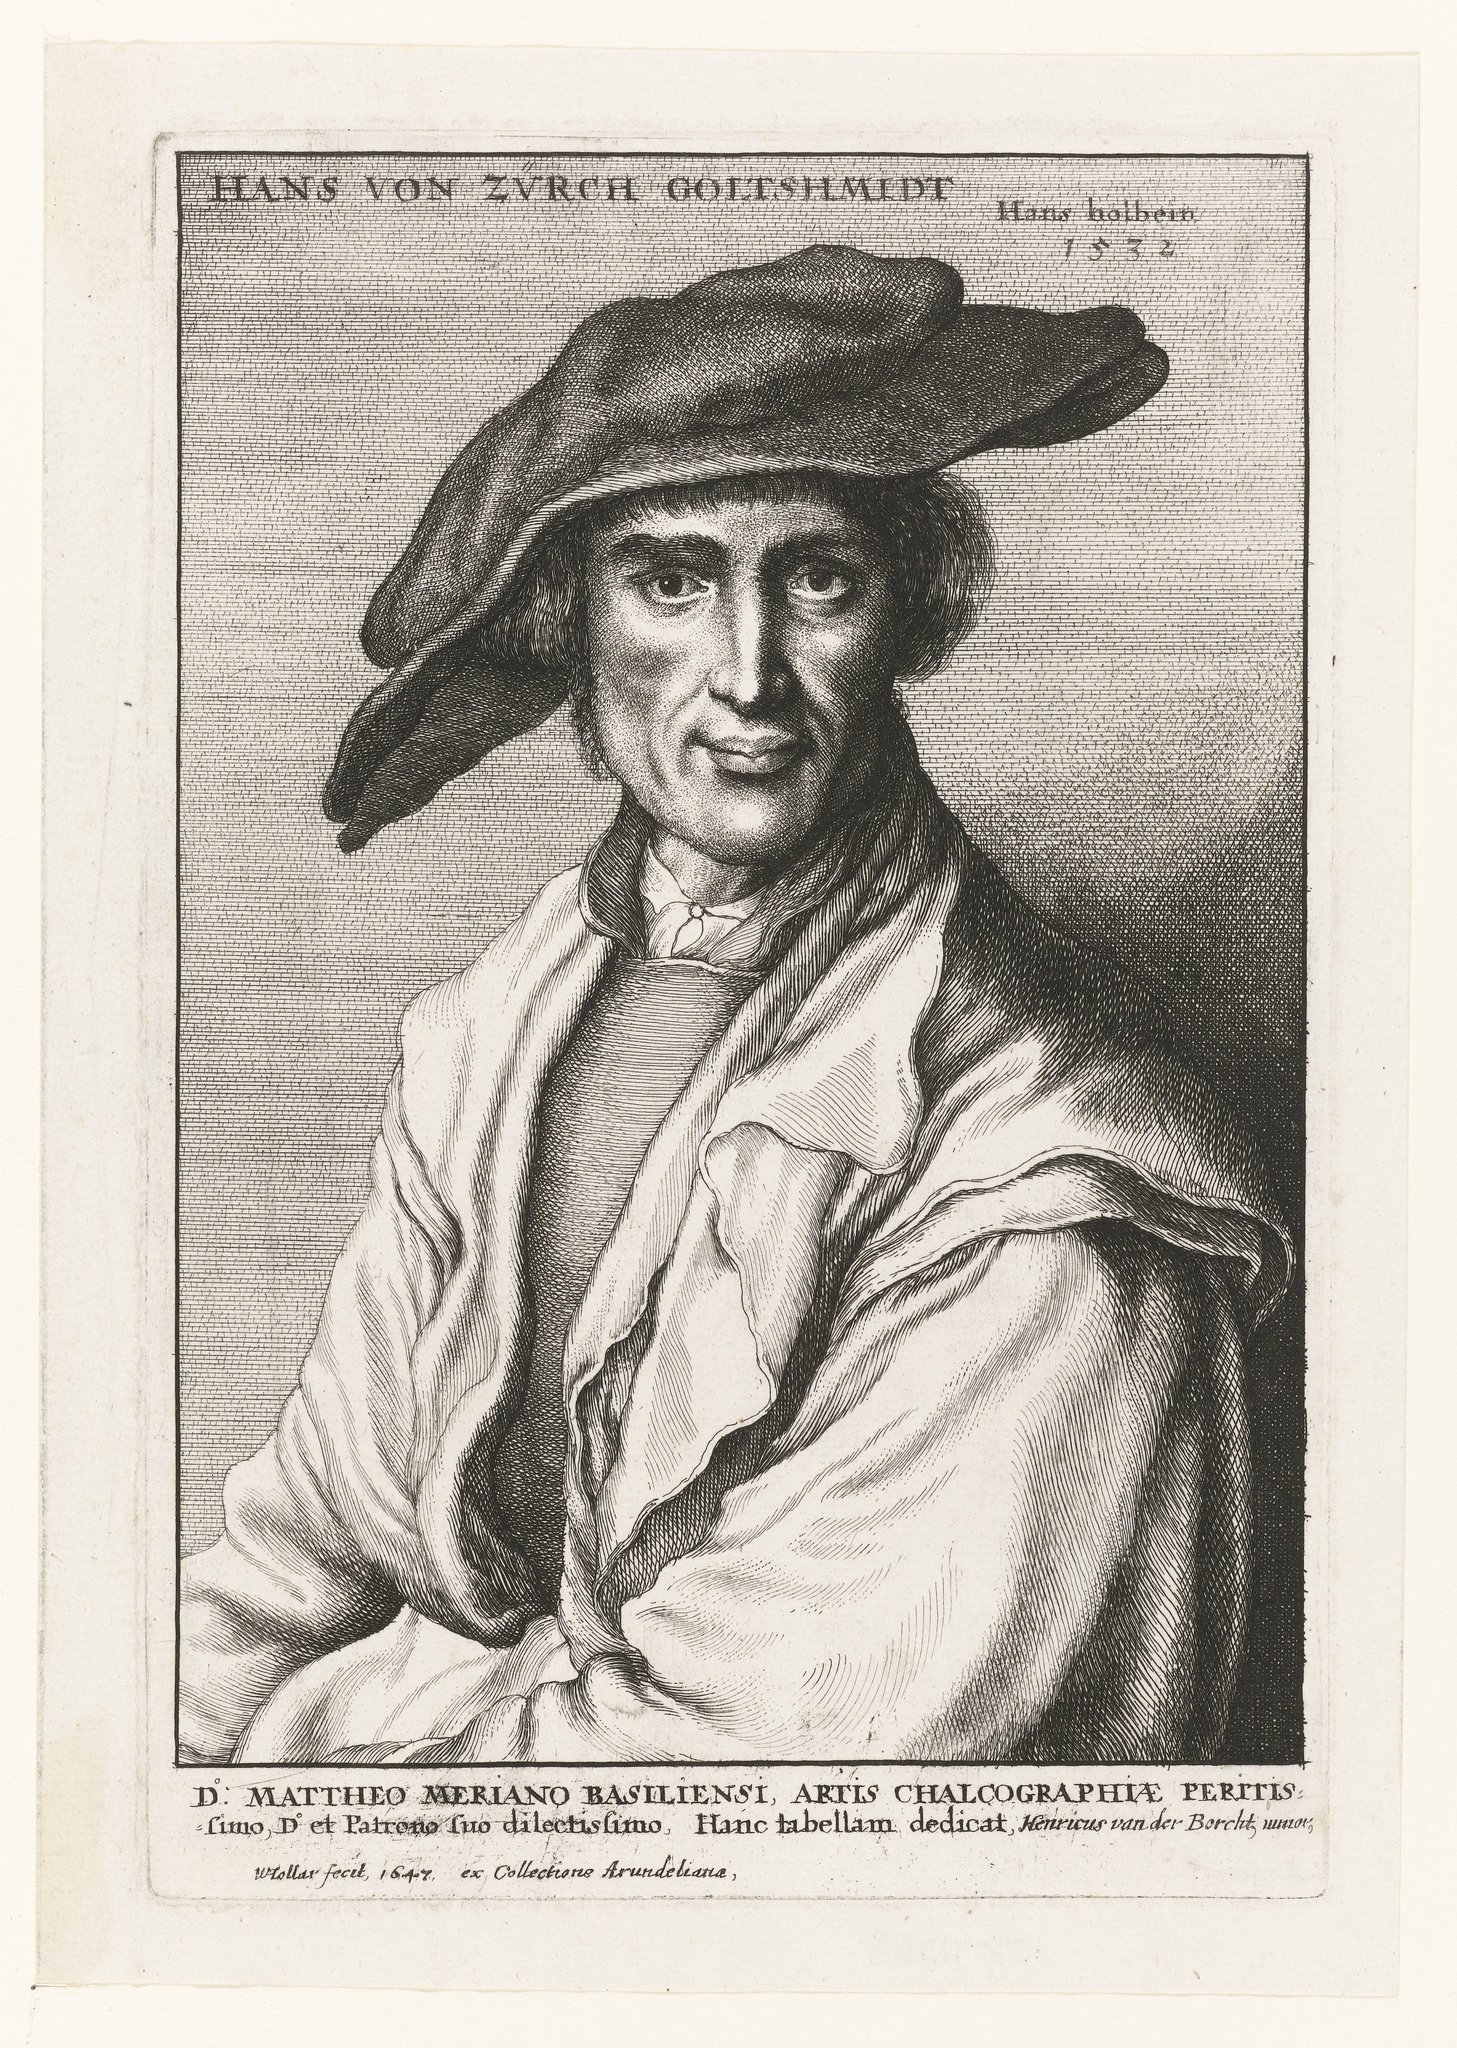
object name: print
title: Portret Hans von Zürich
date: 1647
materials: paper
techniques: etching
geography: antwerp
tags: head-gear: hat (+ men's clothes)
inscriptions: collector's mark: Lugt 240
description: Portret van de Zwitserse goudsmid Hans von Zürich.